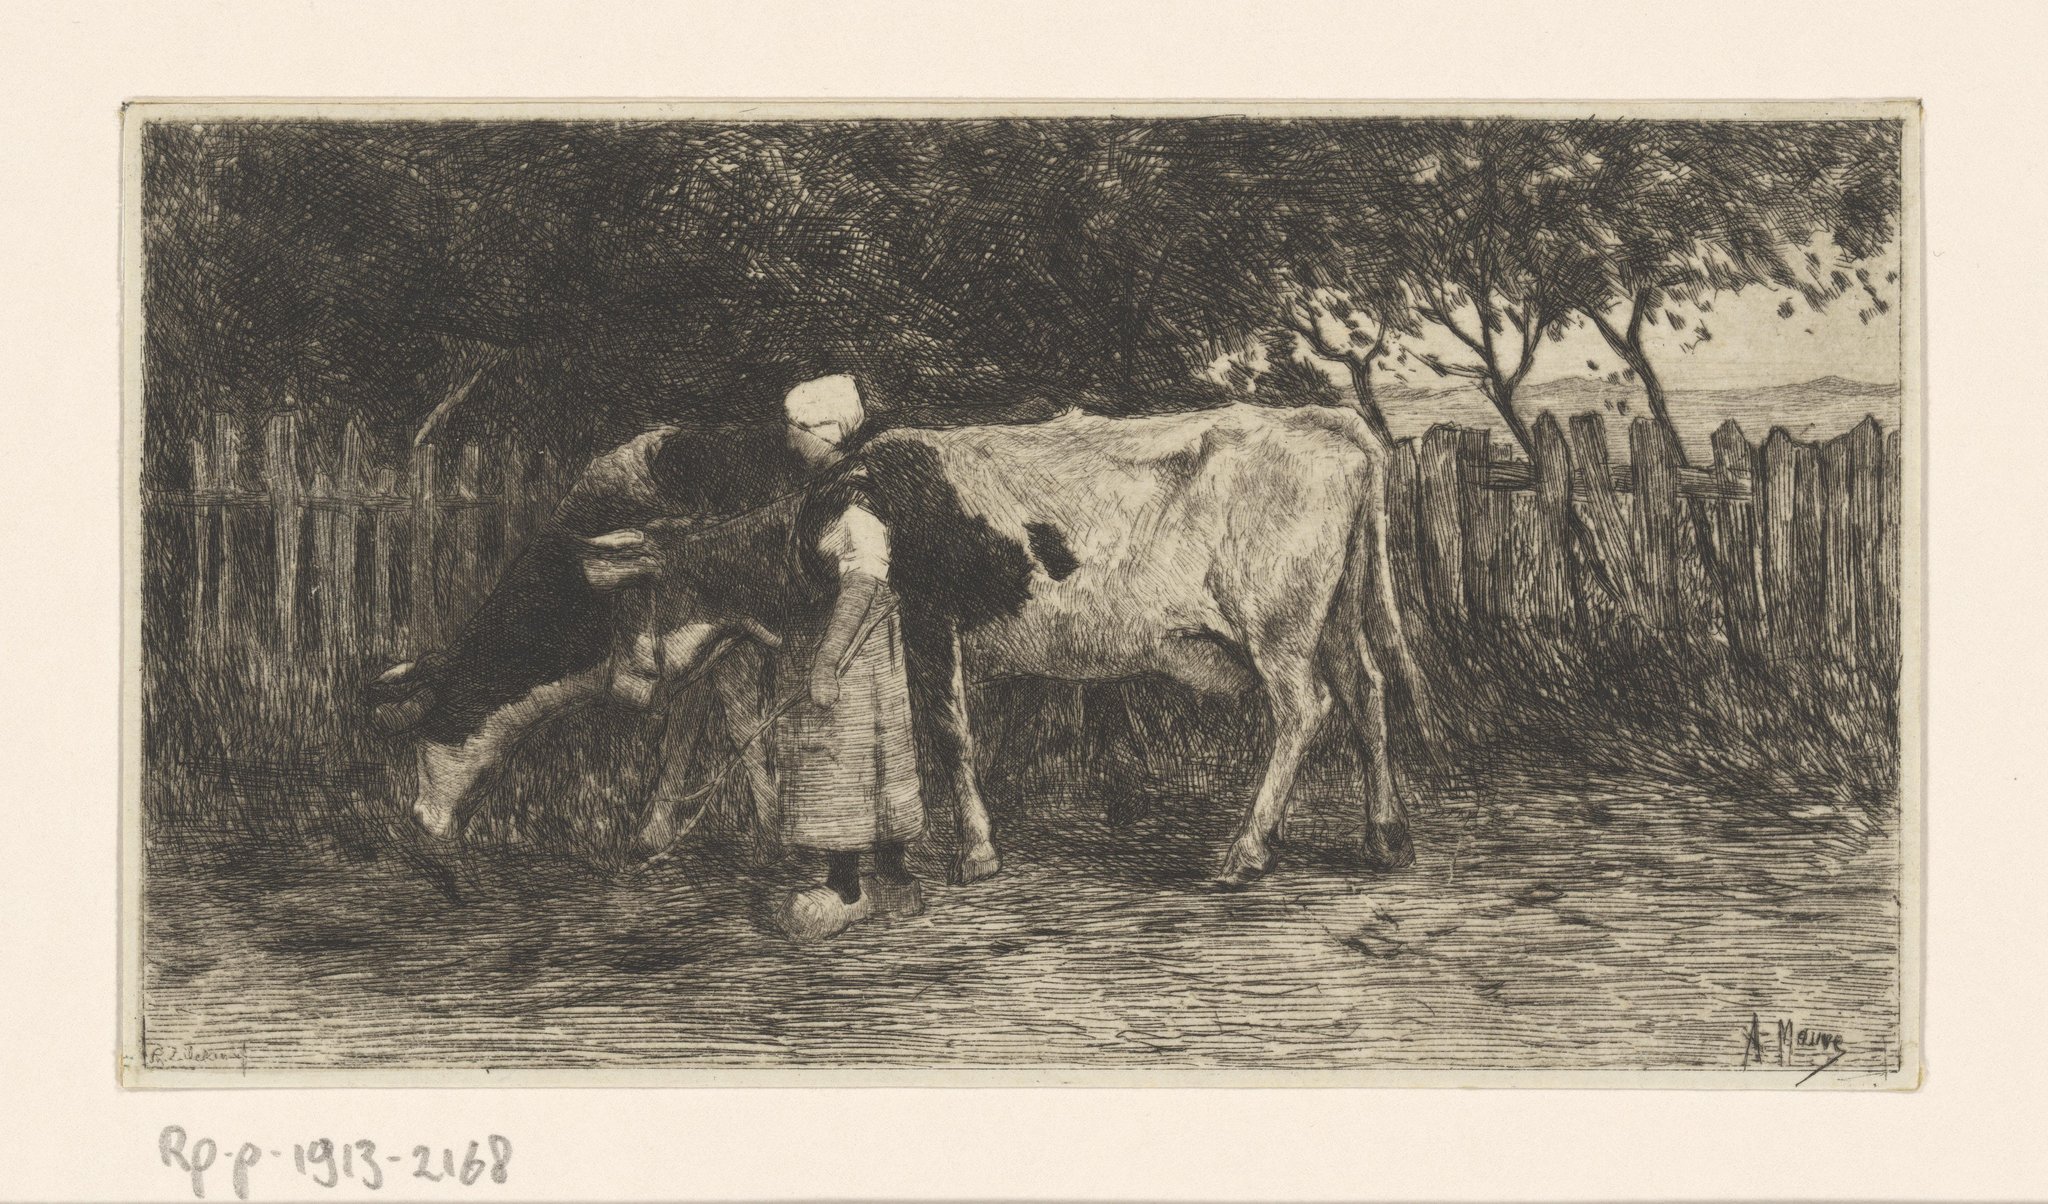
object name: print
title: Jeune fille avec des vaches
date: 1888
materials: paper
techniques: etching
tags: cow, girl (child between toddler and youth)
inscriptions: collector's mark: Lugt 2233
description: Prent is ook gebruikt in: Memorial catalogue of the French and Dutch. Edinburgh: David Douglas, 1888.